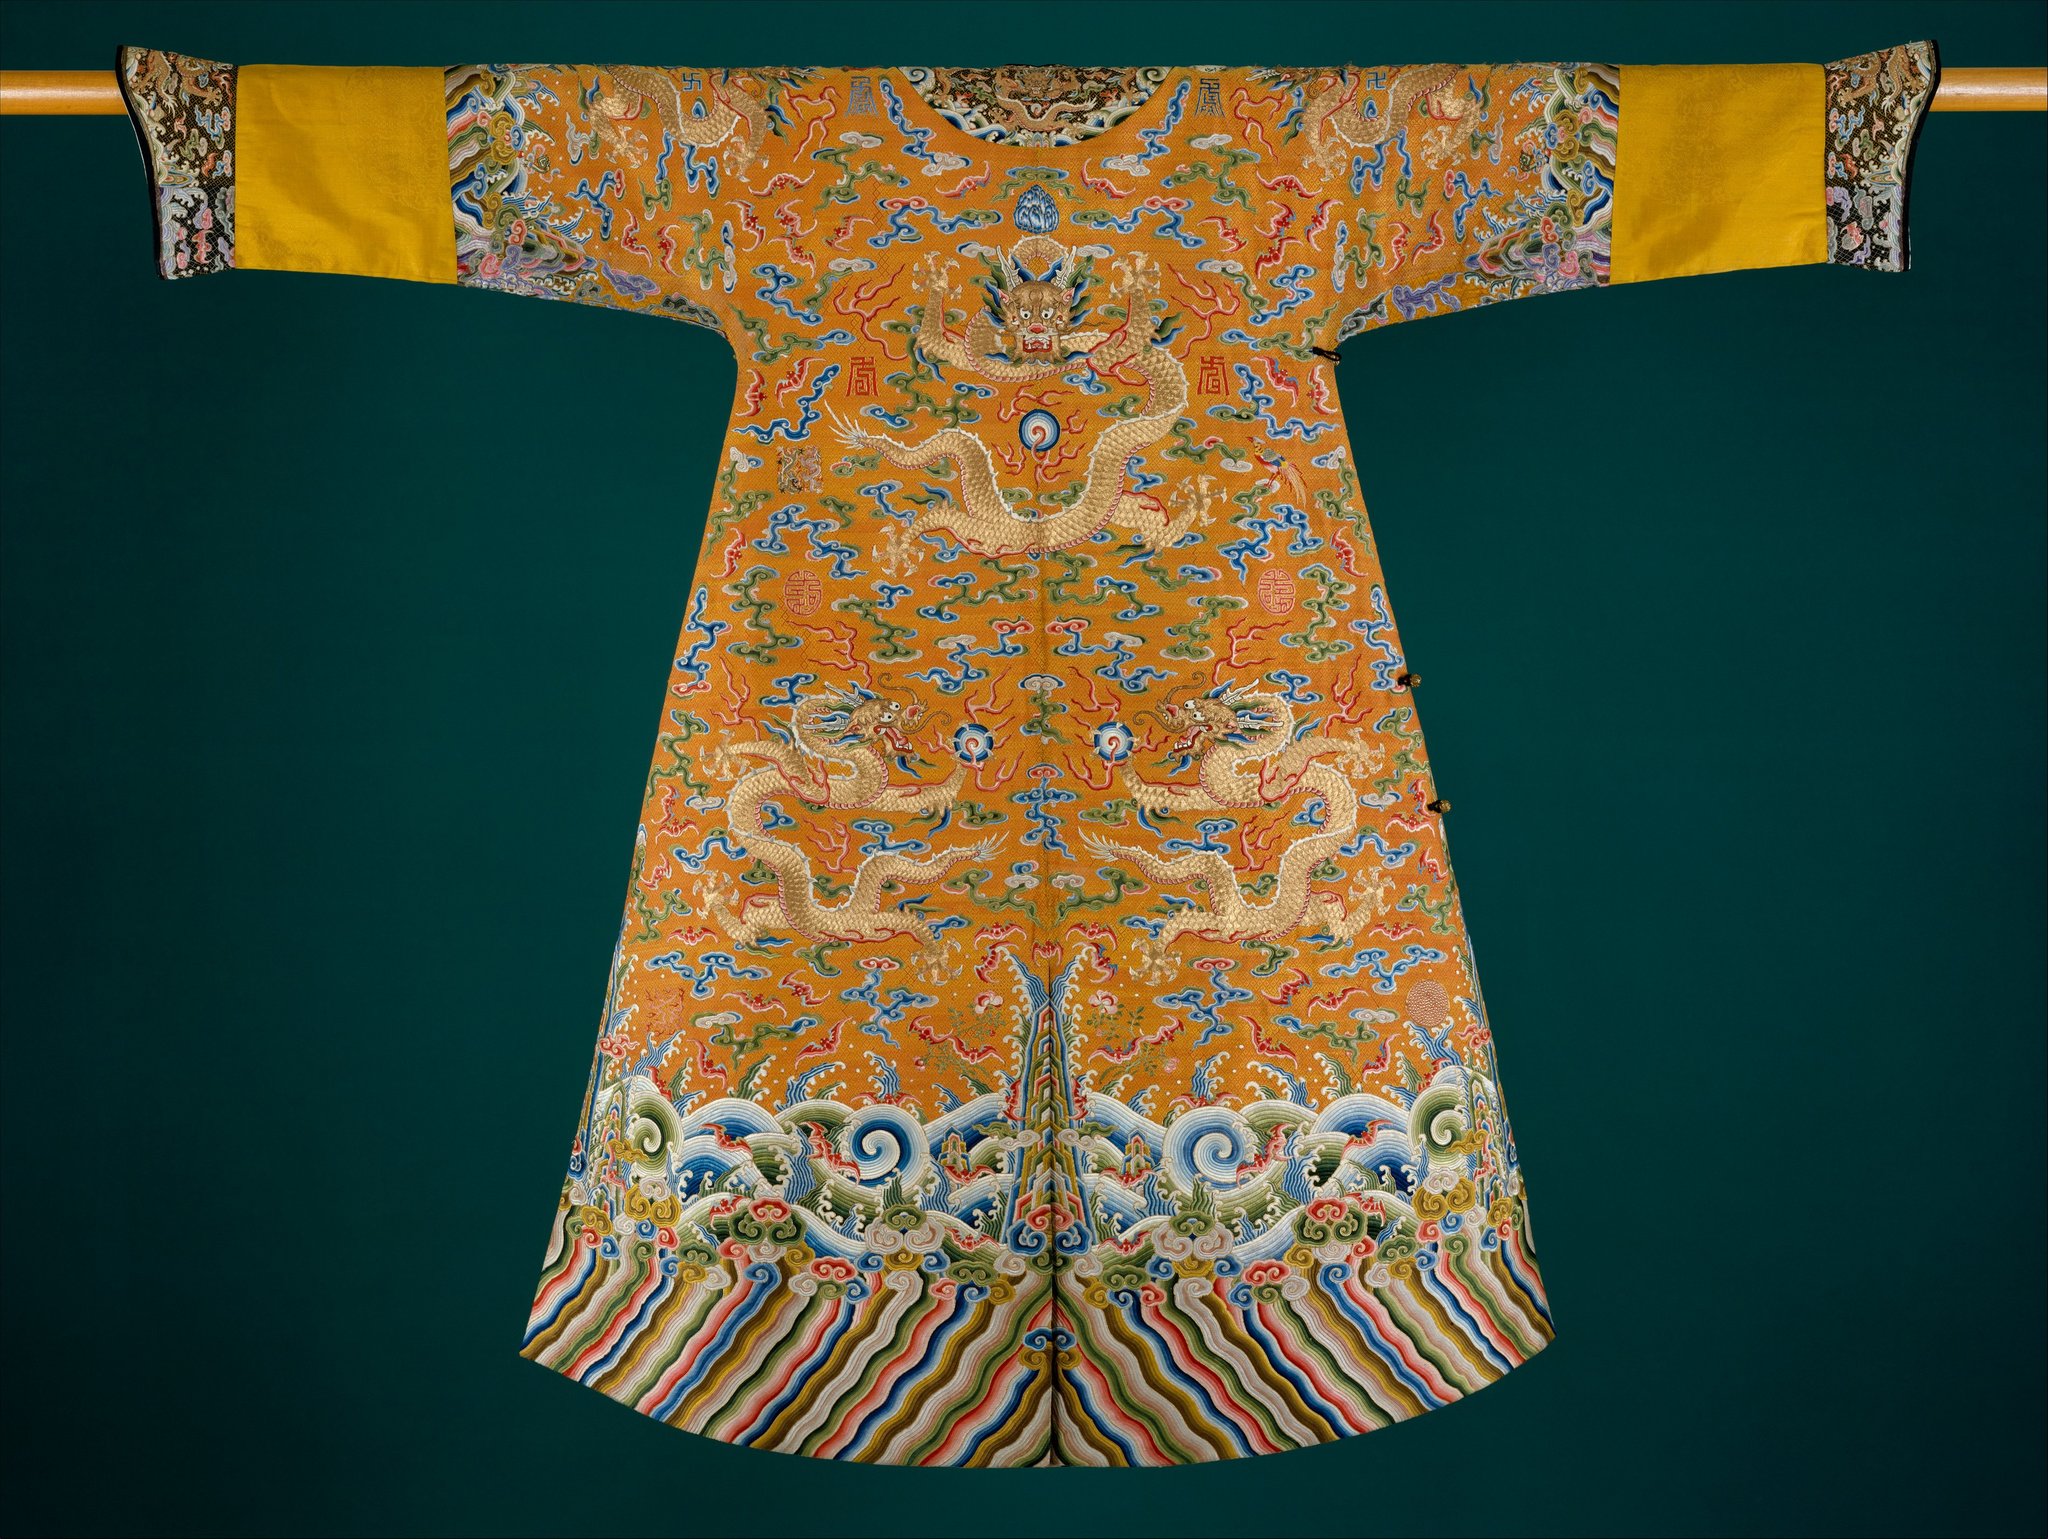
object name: robe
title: Festival Robe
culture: chinese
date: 1751-1800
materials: metal thread, silk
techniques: embroidery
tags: dragons